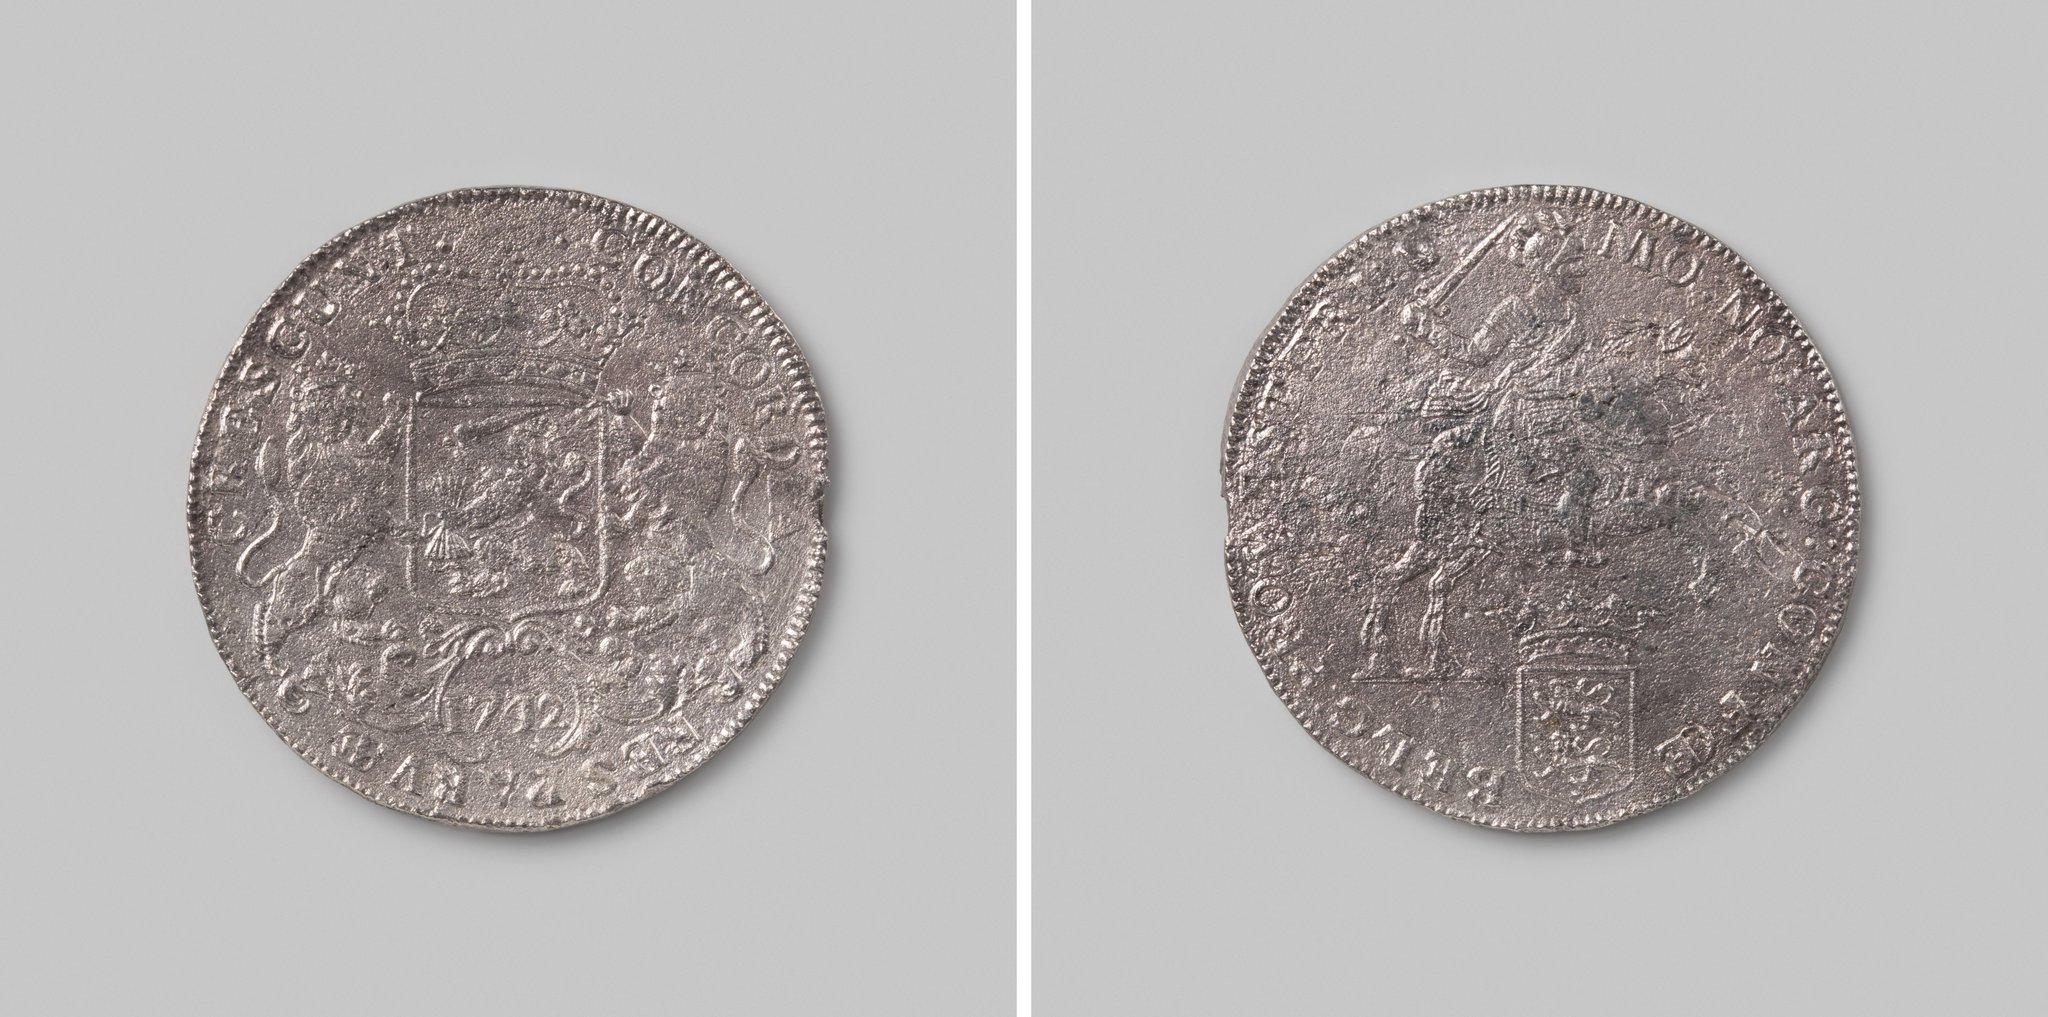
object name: coin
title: Zilveren rijder uit het wrak van de Oost-Indiëvaarder Hollandia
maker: Anonymous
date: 1742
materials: silver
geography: west frisia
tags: verenigde oostindische compagnie, hollandia (schip), annet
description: Economic objects, coin, silver rider (1) circular (4.2d, 0.25t, 30.66gr); West Friesland 1742, obverse and reverse type id. NG 1975-58H, coin.